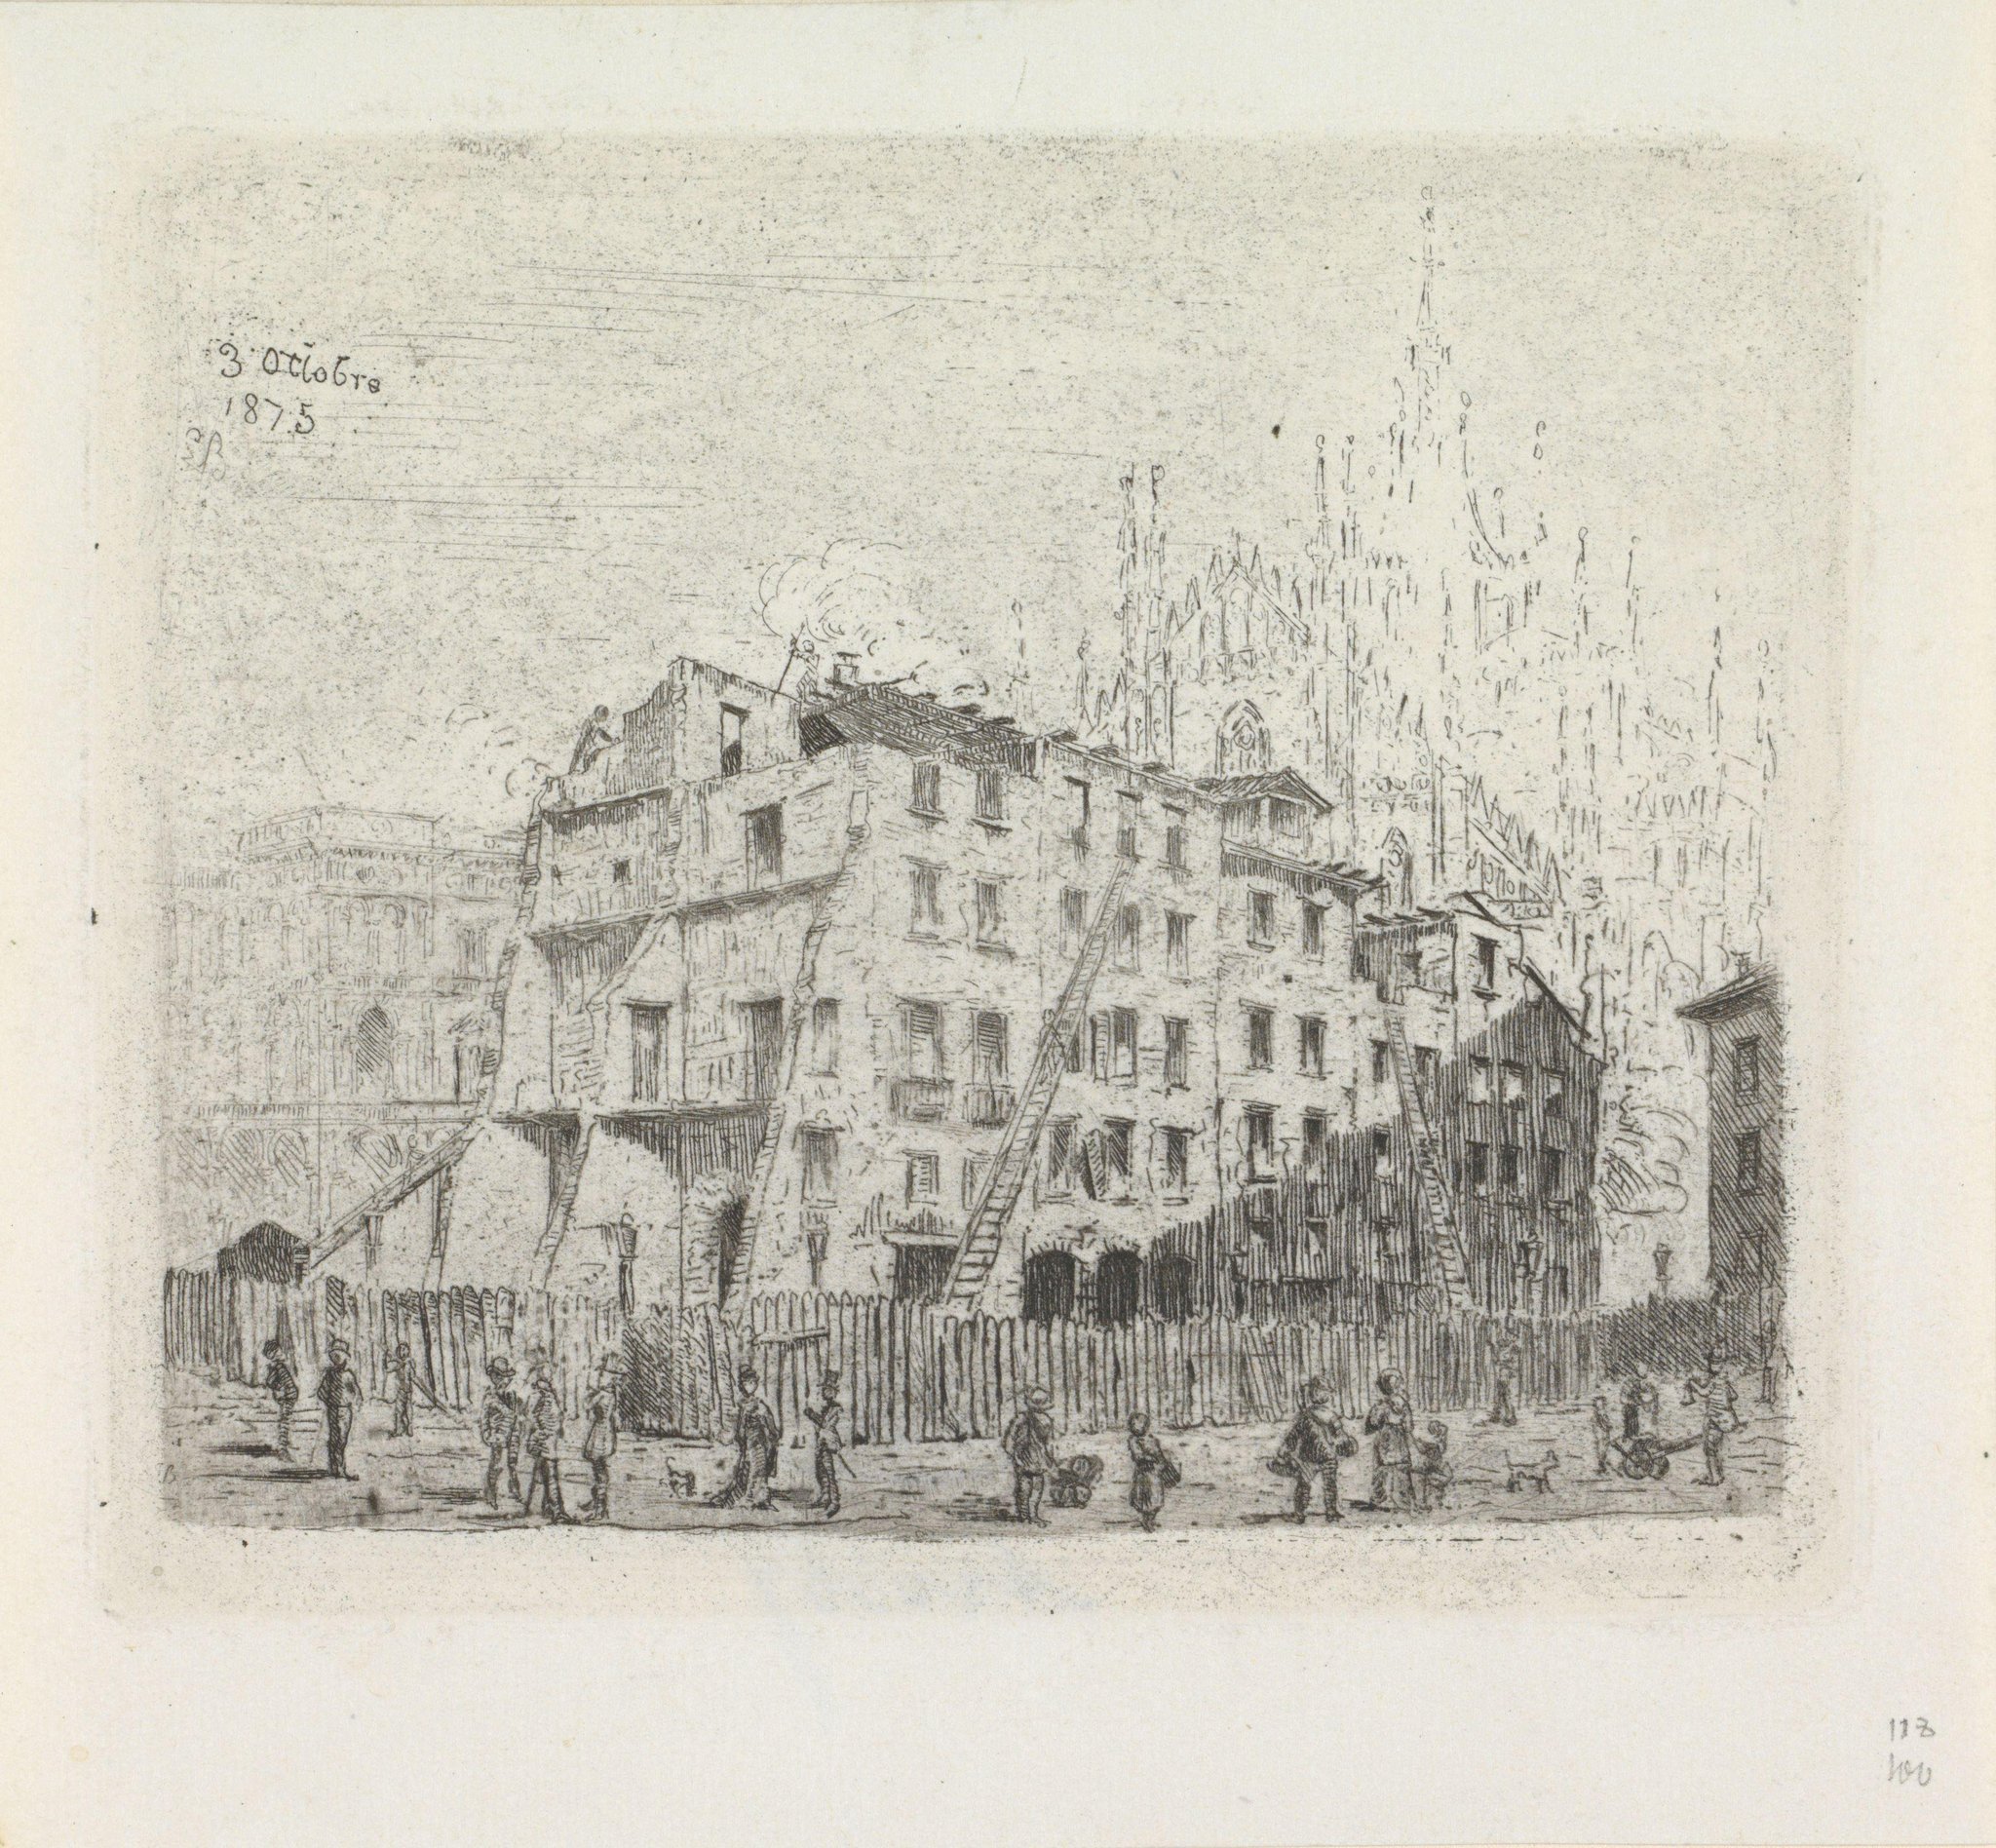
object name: print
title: Gebouwen in Milaan afgebroken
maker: luca beltrami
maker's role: print maker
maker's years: 1854-1933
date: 1875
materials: paper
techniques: etching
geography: italy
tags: demolition of building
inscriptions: collector's mark: Lugt 2228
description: Gebouwen in het historische hart van Milaan worden afgebroken voor de aanleg van het Piazza del Duomo. Op de achtergrond de Dom van Milaan en de Galleria Vittorio Emanuele II.